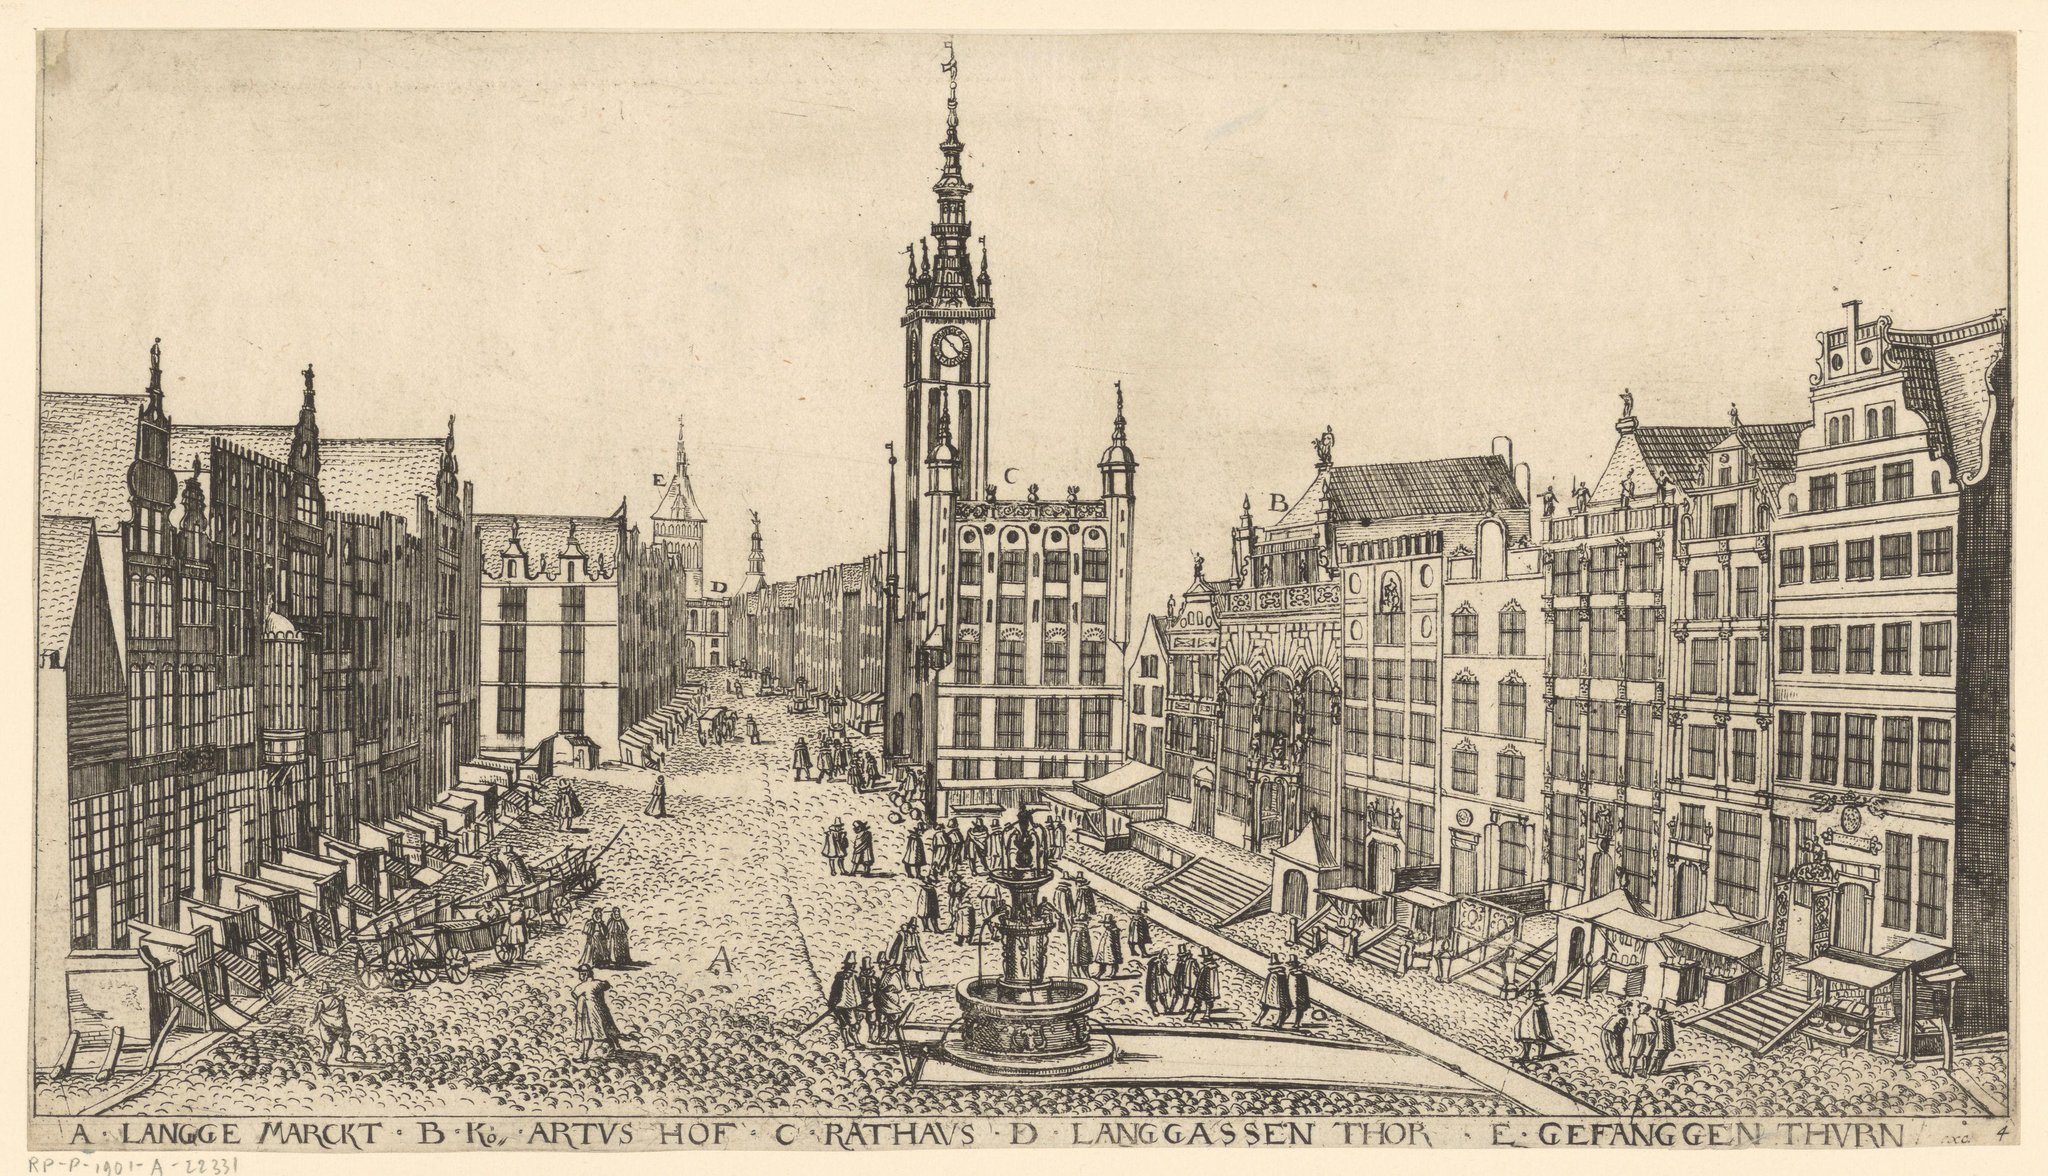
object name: print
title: Gezichten in en om de stad Danzig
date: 1625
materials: paper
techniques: etching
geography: amsterdam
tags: city-view, and landscape with man-made constructions, bourgeoisie, middle class, citizens, burghers, townhall, ornamental fountain, village square, place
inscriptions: collector's mark: Lugt 2228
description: Deze prent behoort tot een serie van veertien prenten betreffende de stad Danzig. Verklarende legenda onder de prent.